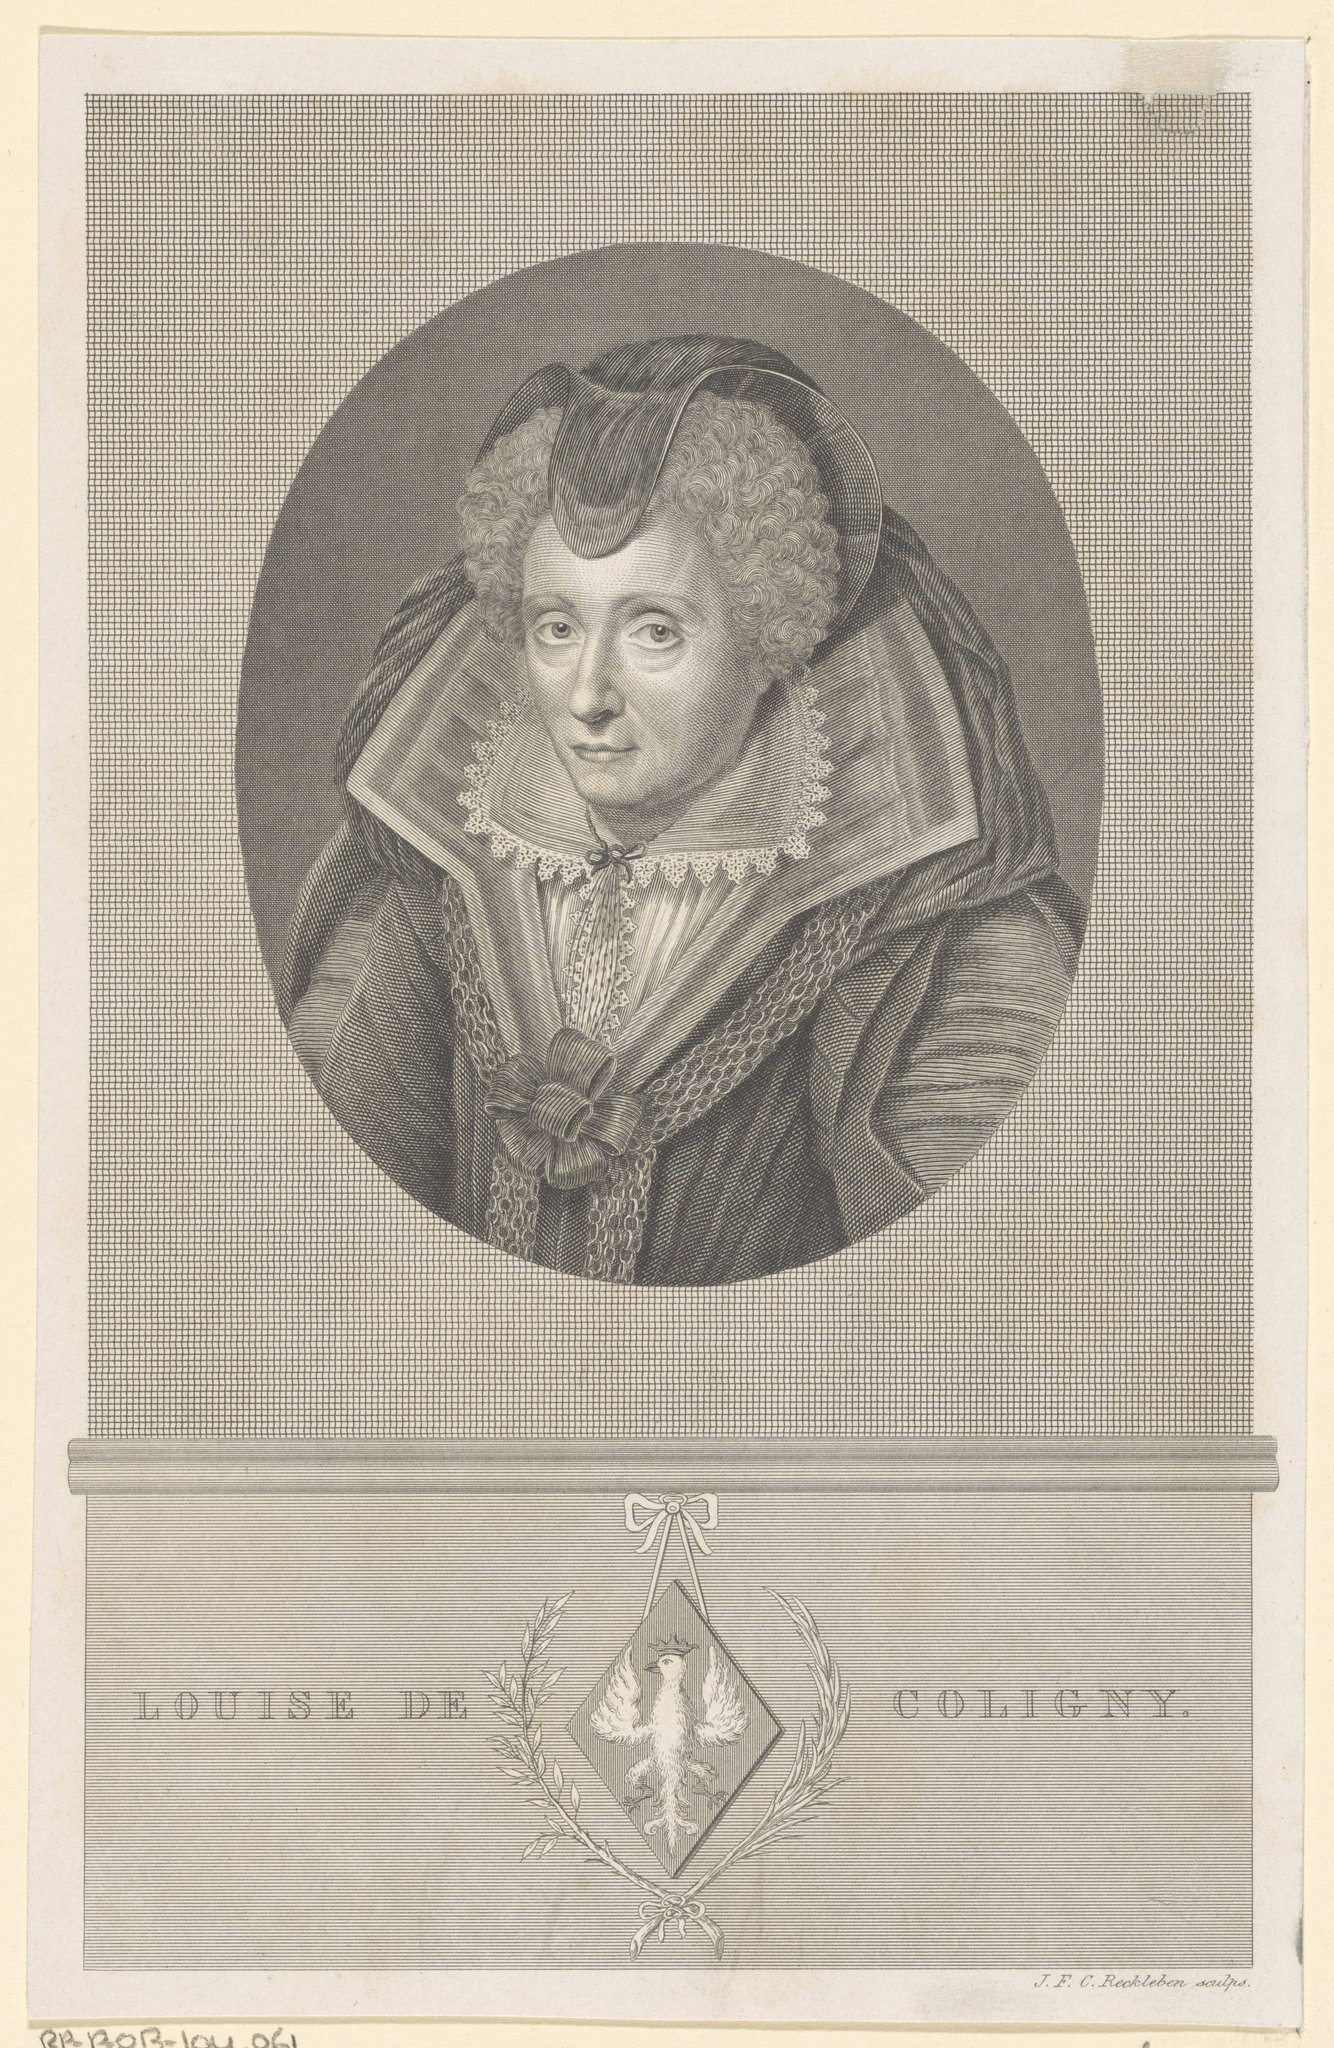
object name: print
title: Portret van Louise de Coligny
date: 1840-1884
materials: paper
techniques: engraving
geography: amsterdam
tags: louise de coligny, neck-gear: collar (+ women's clothes)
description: De hier vermelde titel verwijst naar de hoogst verkregen titel van de geportretteerde, niet per se naar de titel die de geportretteerde op deze voorstelling draagt. Prent uit: Arend, Johannes Pieter. Algemeene geschiedenis des vaderlands van de vroegste tijden tot op heden. Amsterdam: J.F. Schleijer, 1840-1884.